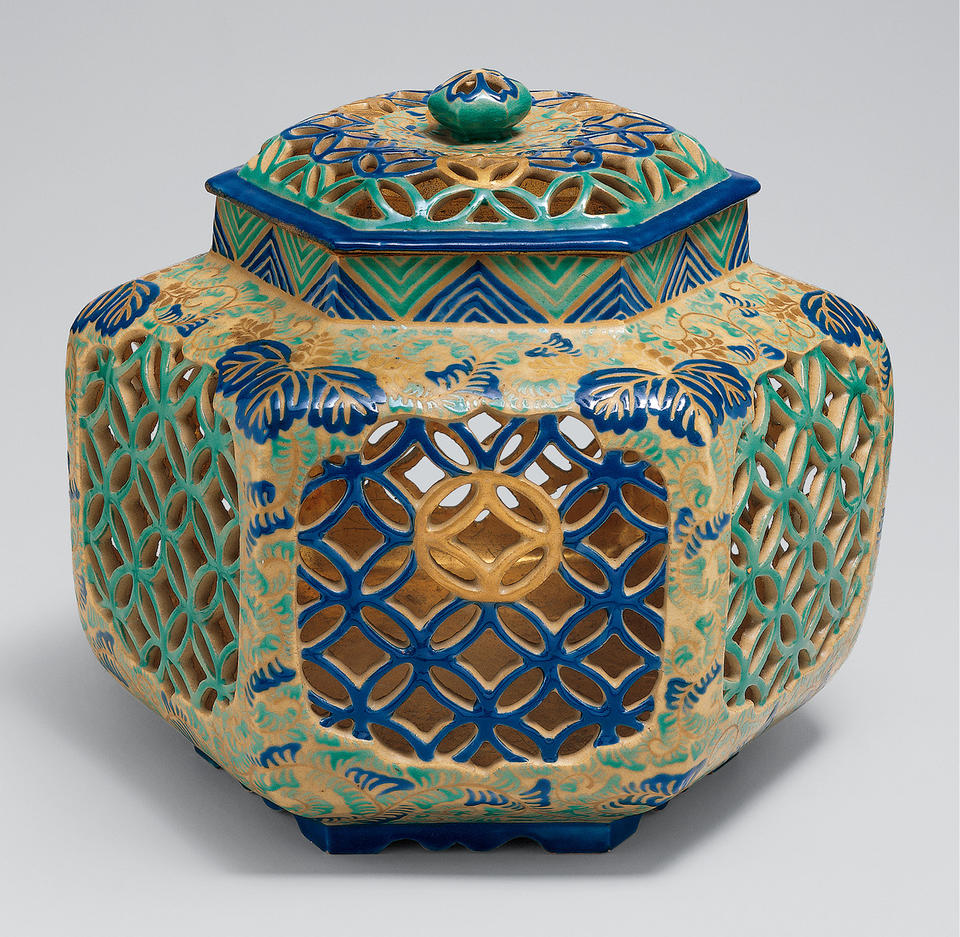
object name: brazier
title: Hexagonal Jar (Rokkaku-tsubo) with Paulownia and Geometric Design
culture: japanese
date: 1701-1800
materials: enamel, gold, stoneware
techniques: overglaze, polychrome